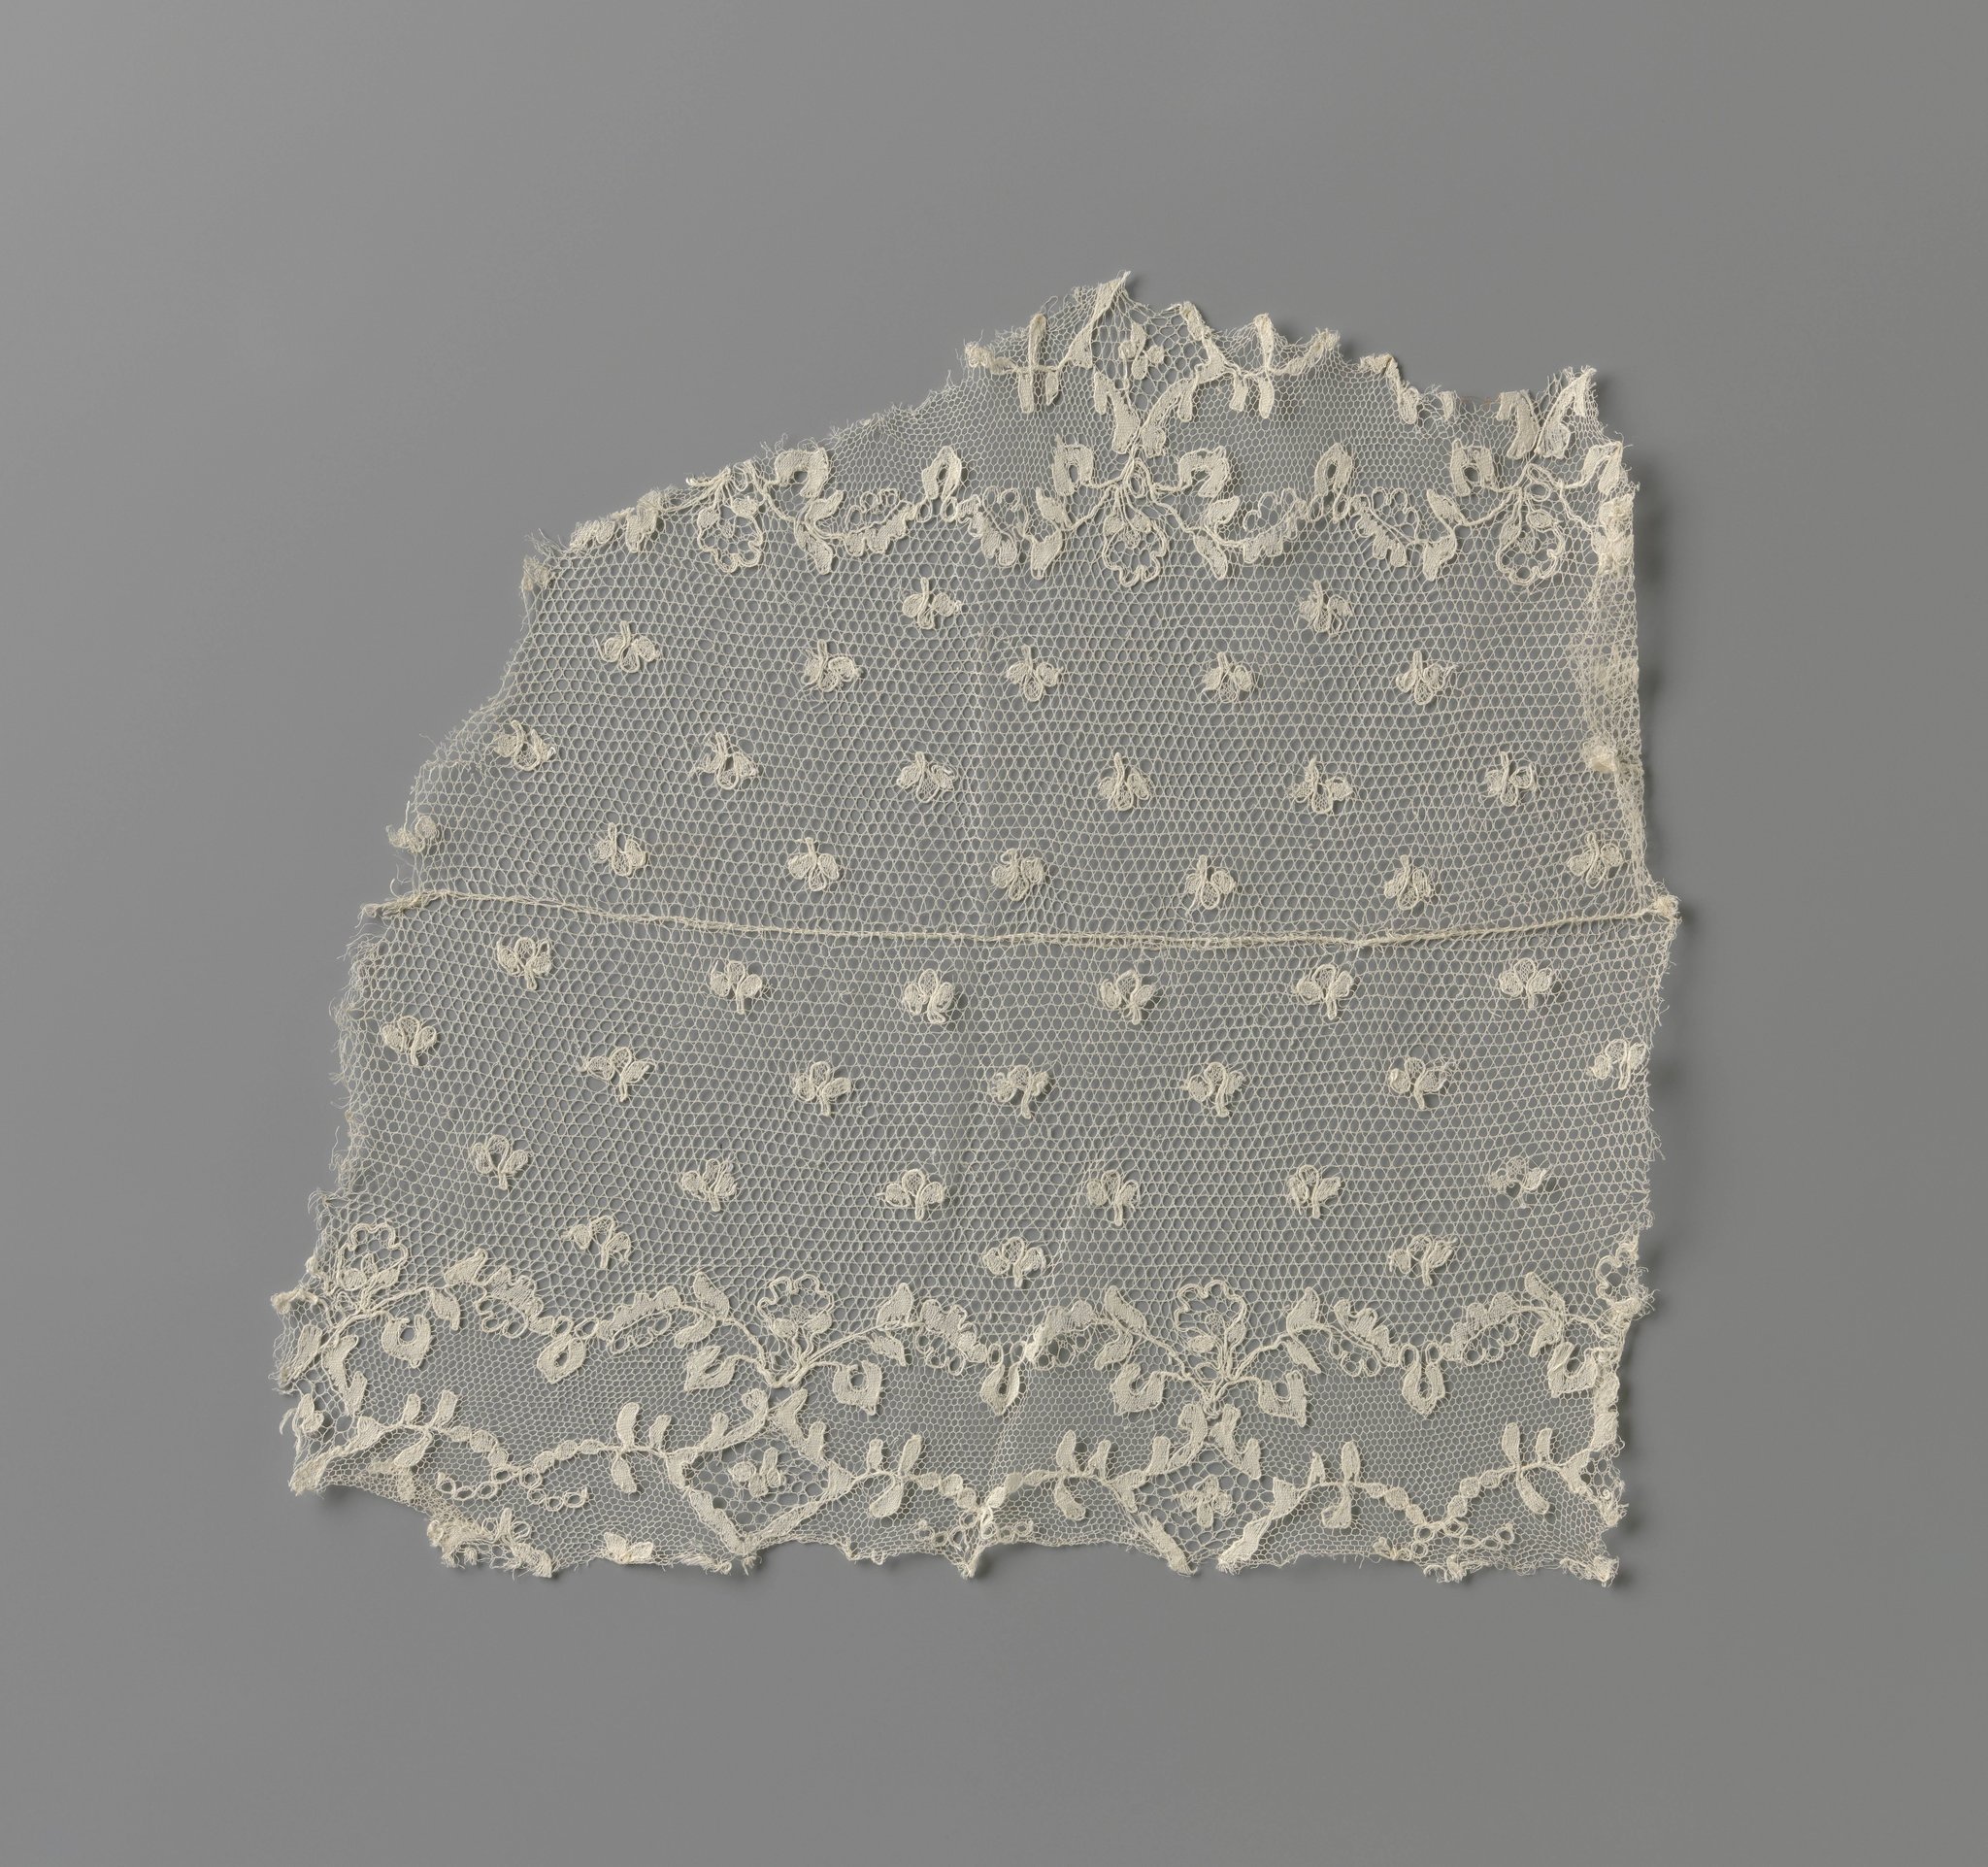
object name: dust ruffle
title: Volant van kloskant met ruitvormige medaillons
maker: Anonymous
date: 1870-1920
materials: linen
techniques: lace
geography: belgium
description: Volant van naturelkleurige kloskant: Parijse kant. De grond is in tweeën gedeeld in een Parijse grond met klaverblaadjes bovenaan en een tulegrond daaronder. In de laatste staat een symmetrisch patroon van ruitvormige opengewerkte medaillons met zijranken bekroond door een bloem tussen twee bladeren. De bladeren, de zijranken en een reeks bloempjes en rankjes in de schulprand staan in drie gesloten slingers los boven elkaar. De motieven zijn gemaakt in linnenslag en voorzien van contourdraden. Als siergrond is een rozengrond toegepast. BK-BR-J-375-H en -J zijn in de lengte aan elkaar genaaid. Bij beide stroken is de onderrand verknipt. Bij -J is de zijkant schuin afgeknipt.